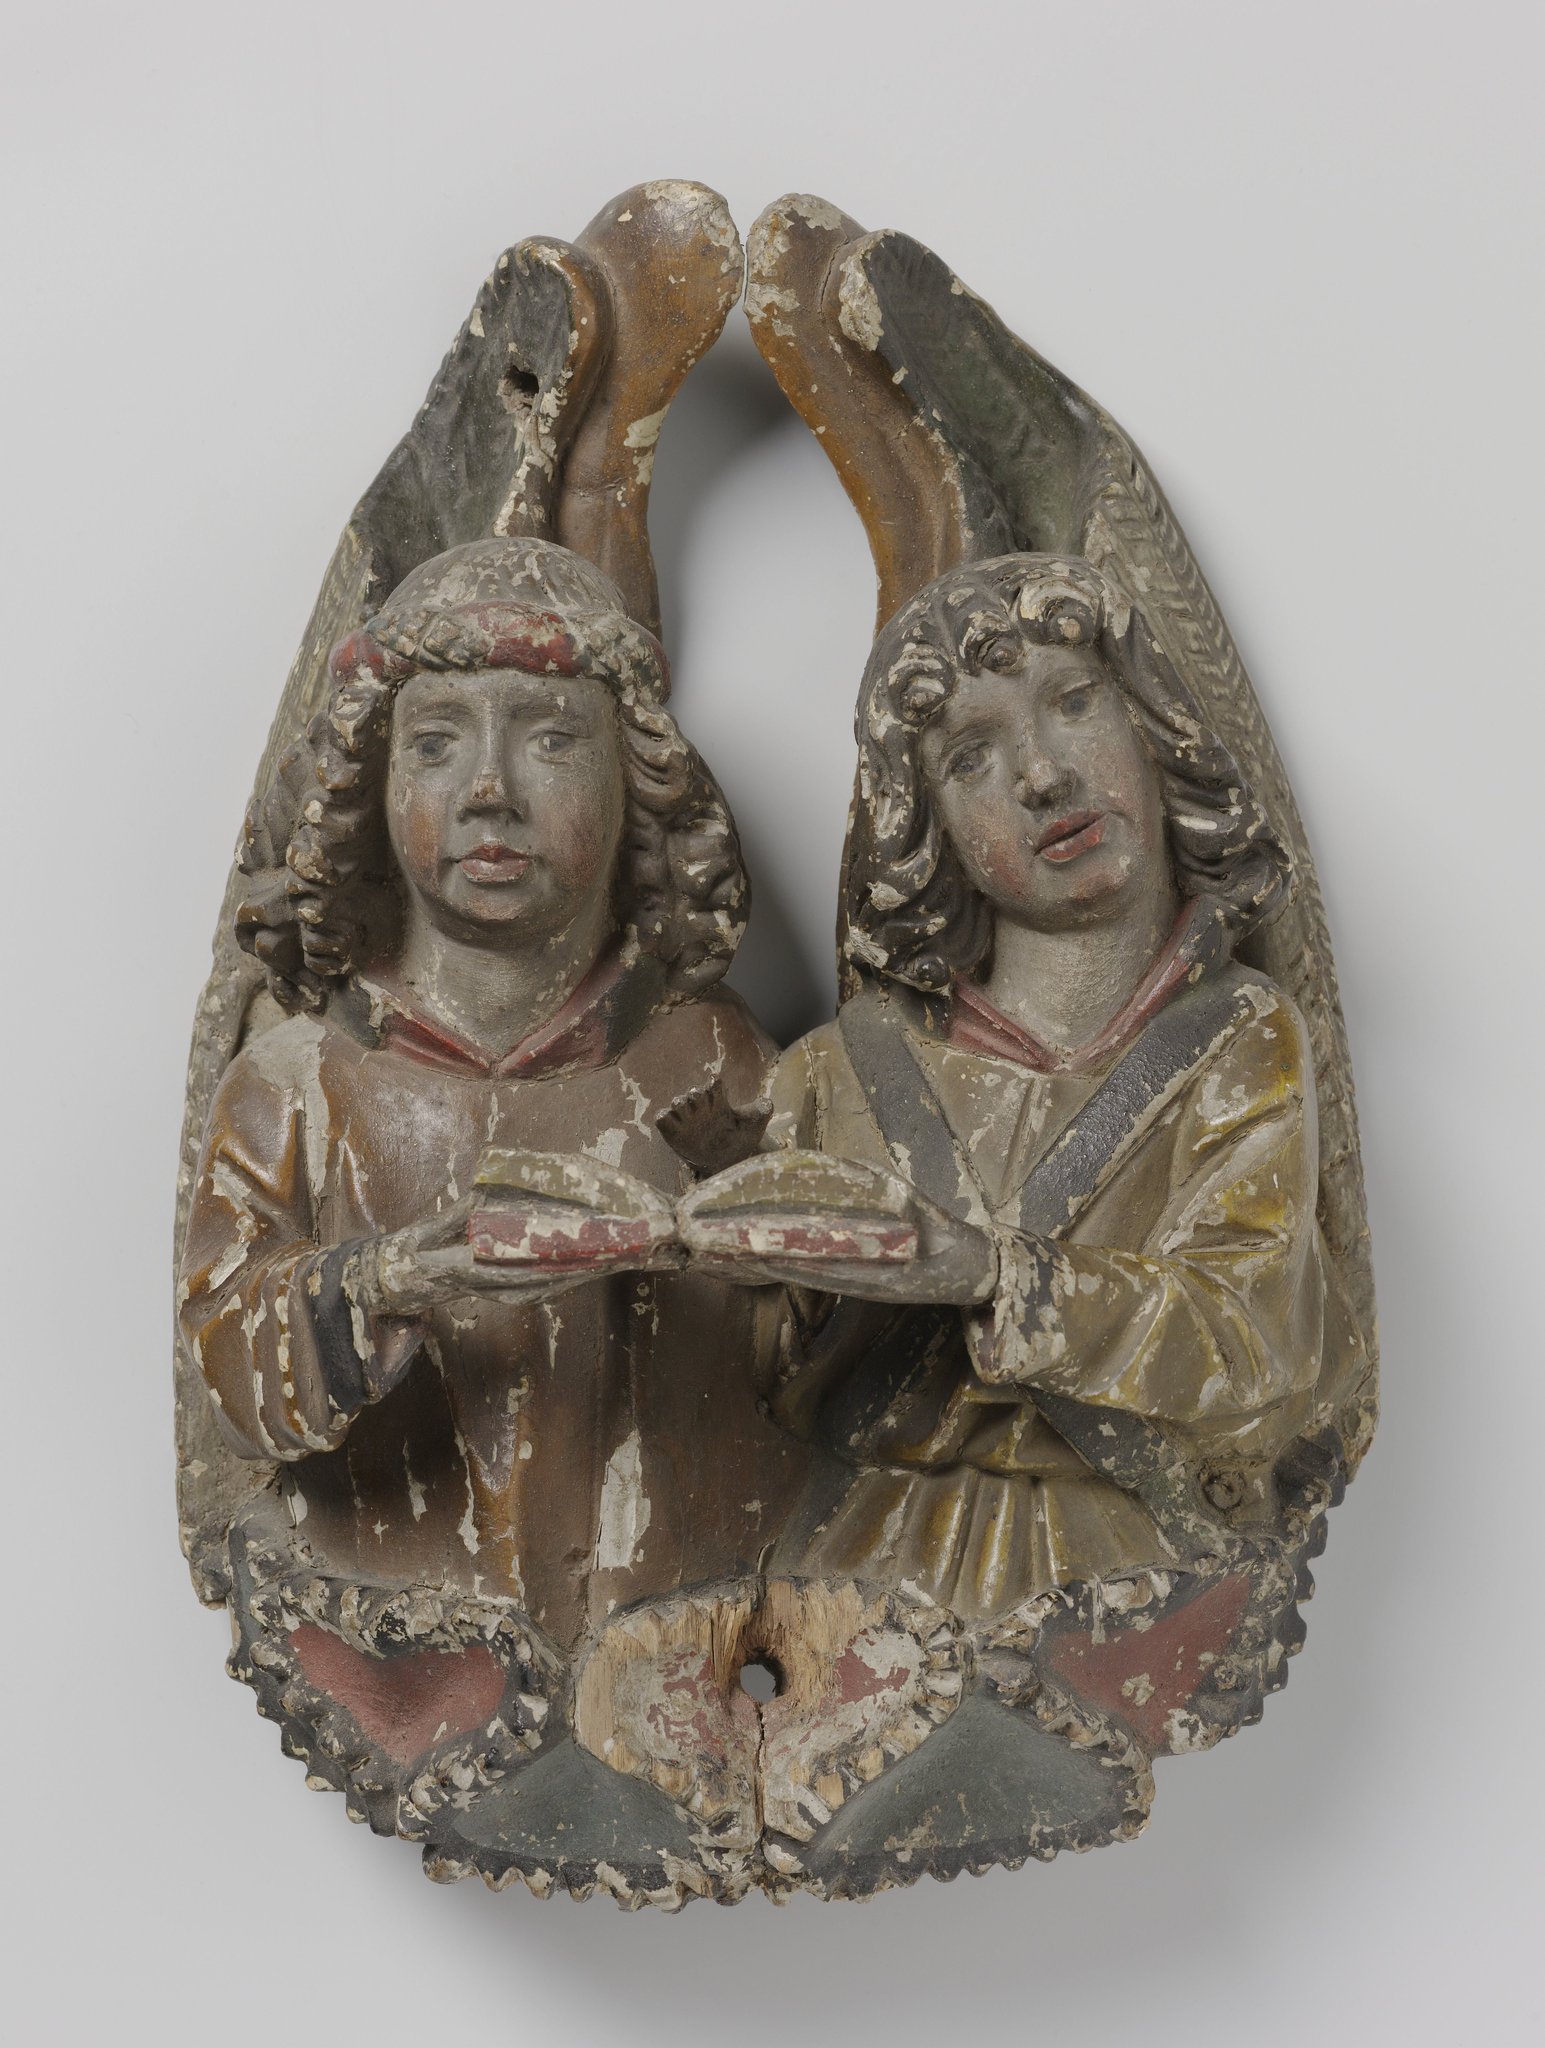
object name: sculpture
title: Twee zingende engeltjes met boek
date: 1500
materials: wood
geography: swabia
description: De naast elkaar geplaatste halffiguurtjes gaan onder de middel over in gestilleerde wolken. Zij houden samen een opengeslagen boek vast, terwijl het rechter engeltje met zijn rechter hand de maat aangeeft. Hun vleugels zijn naar boven samengeklapt. Zij dragen albe en amiet, het rechter een stool gekruist voor de borst, het linker een gewonden band om het hoofd.